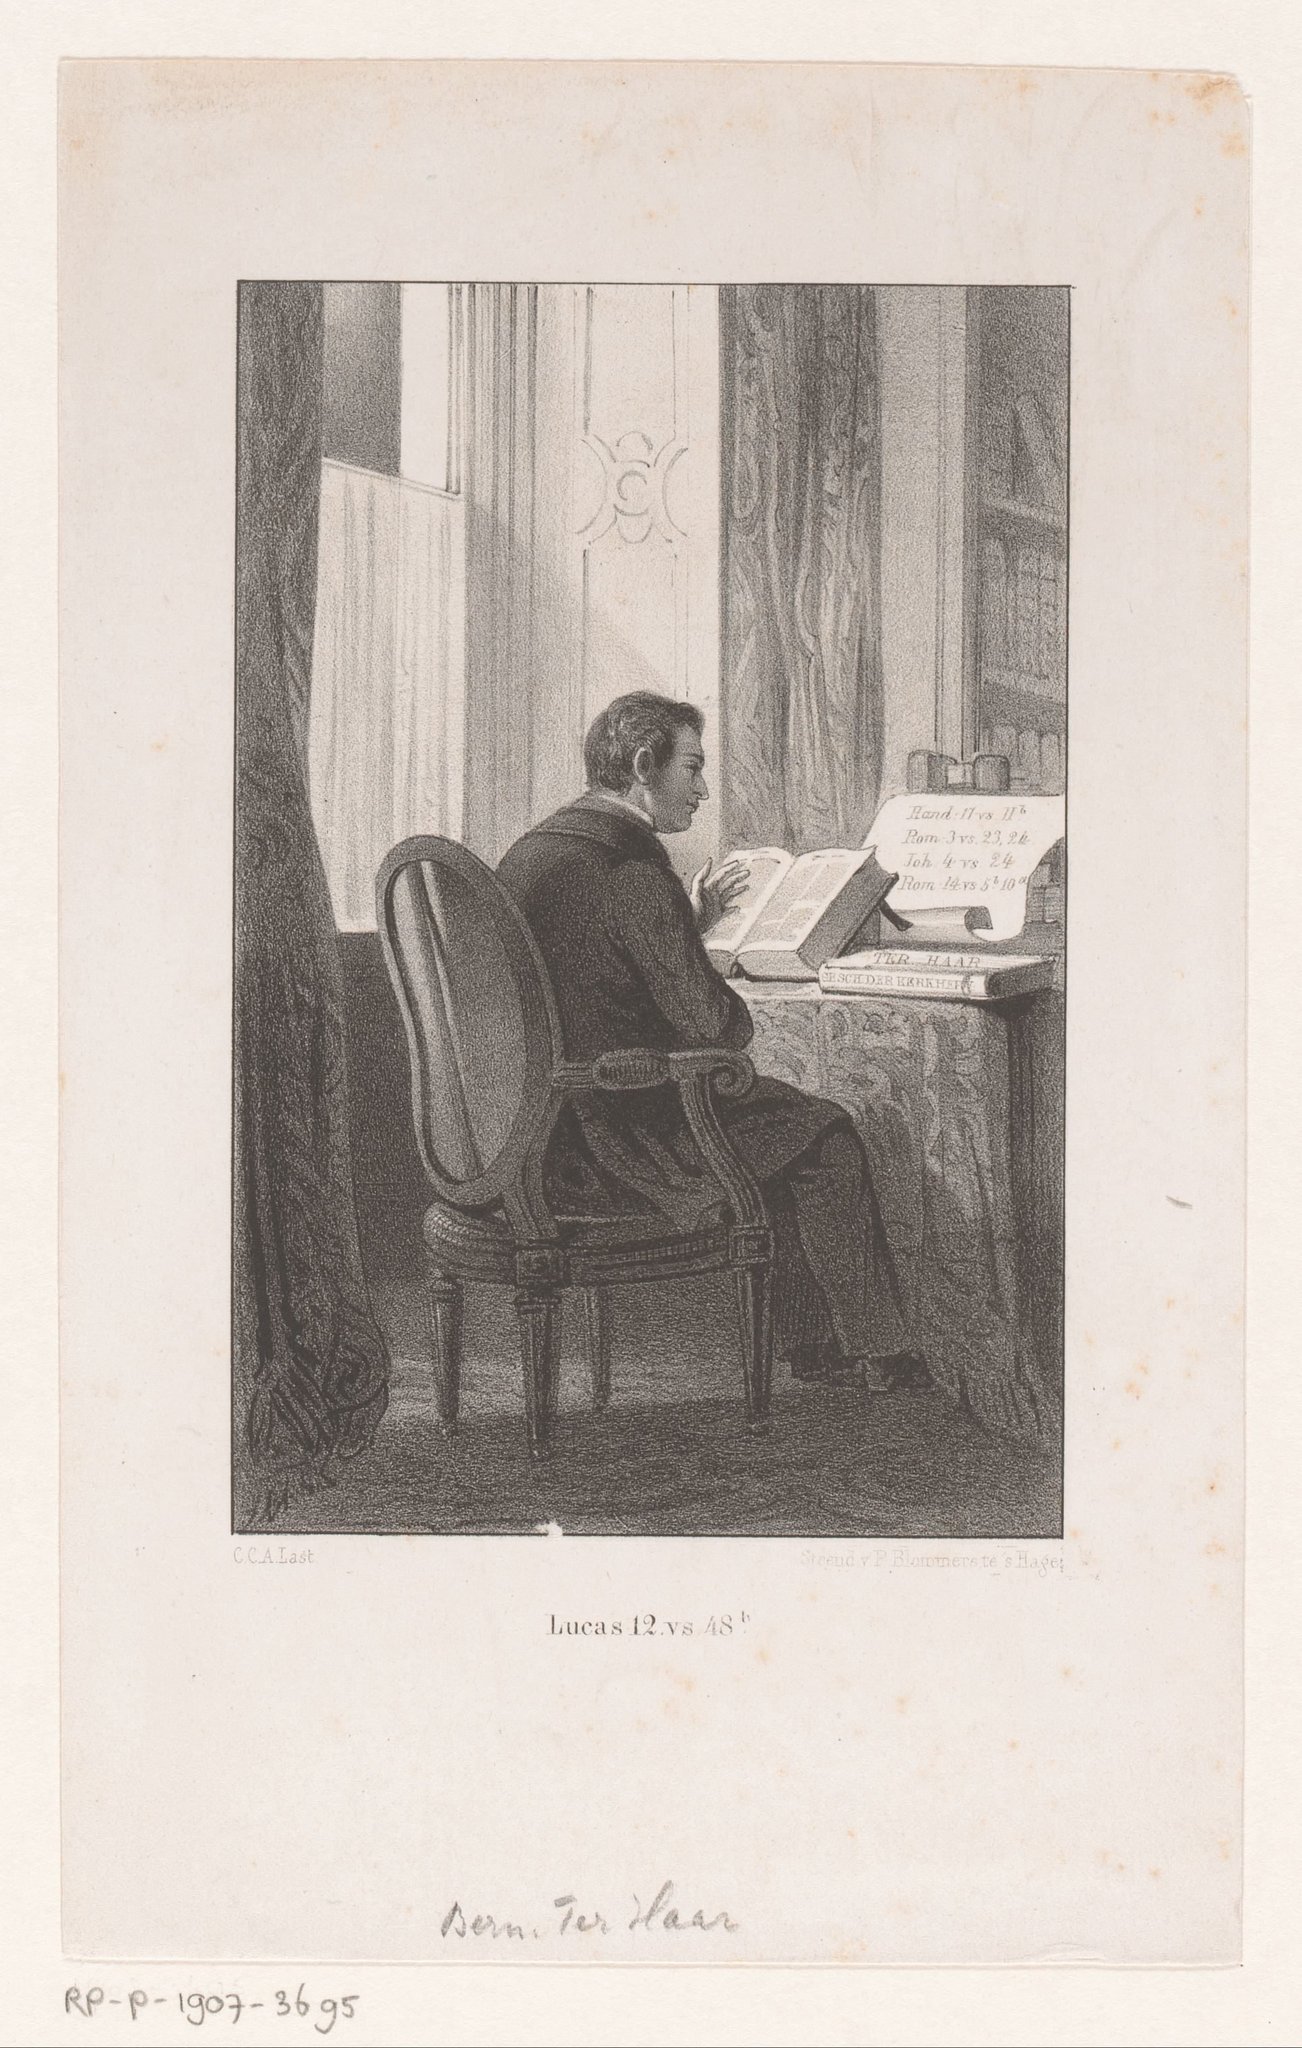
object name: print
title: Bernard ter Haar in zijn werkkamer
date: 1842-1887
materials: paper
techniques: lithograph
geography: the hague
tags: amsterdam, bernard ter haar, scholar in his study, reading the bible or other religious books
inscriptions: collector's mark: Lugt 2228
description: De geportretteerde is op de rug gezien. Hij zit aan tafel voor een opengeslagen boek. Op een gesloten boek dat voor hem ligt staat: 'gesch der kerkherv', verwijzend naar zijn publicatie uit 1845 getiteld: 'Taferelen uit de geschiedenis der kerkhervorming'. Op de tafel staat een vel papier met verwijzingen naar Bijbelverzen. Onder het portret: 'Lucas 12 vs 48b'.